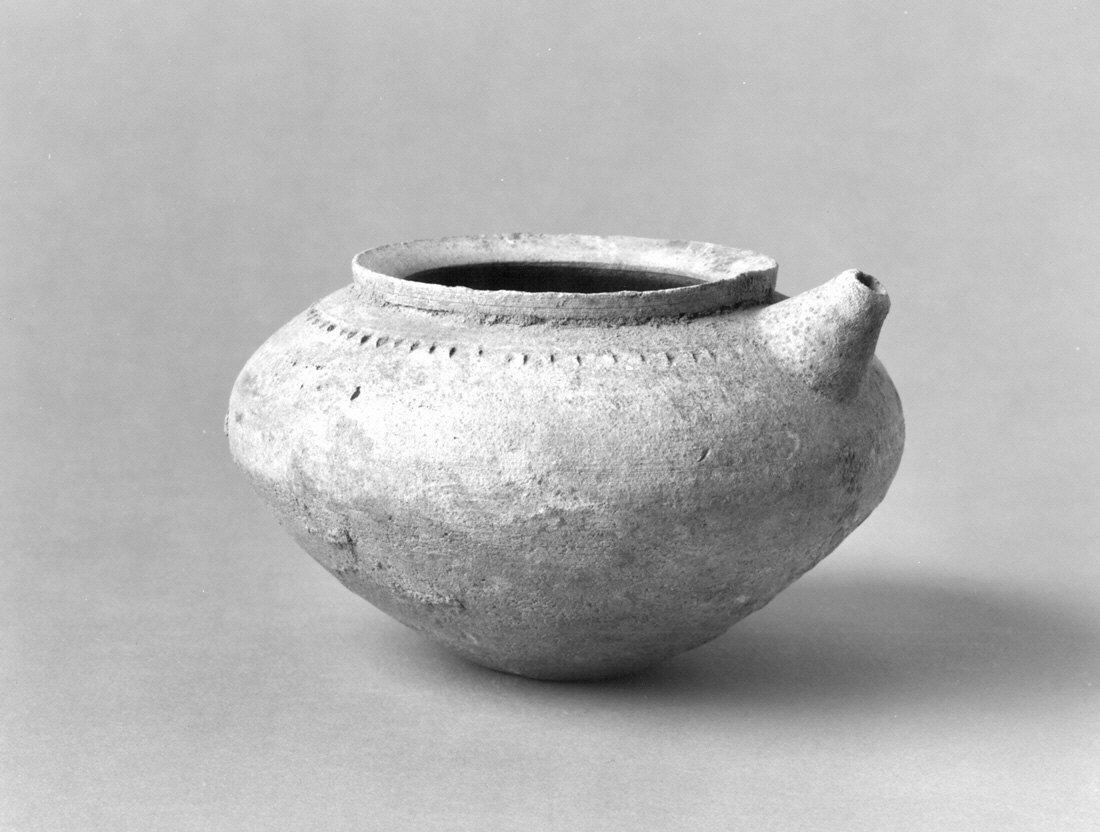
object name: vessel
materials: ceramic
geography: syria